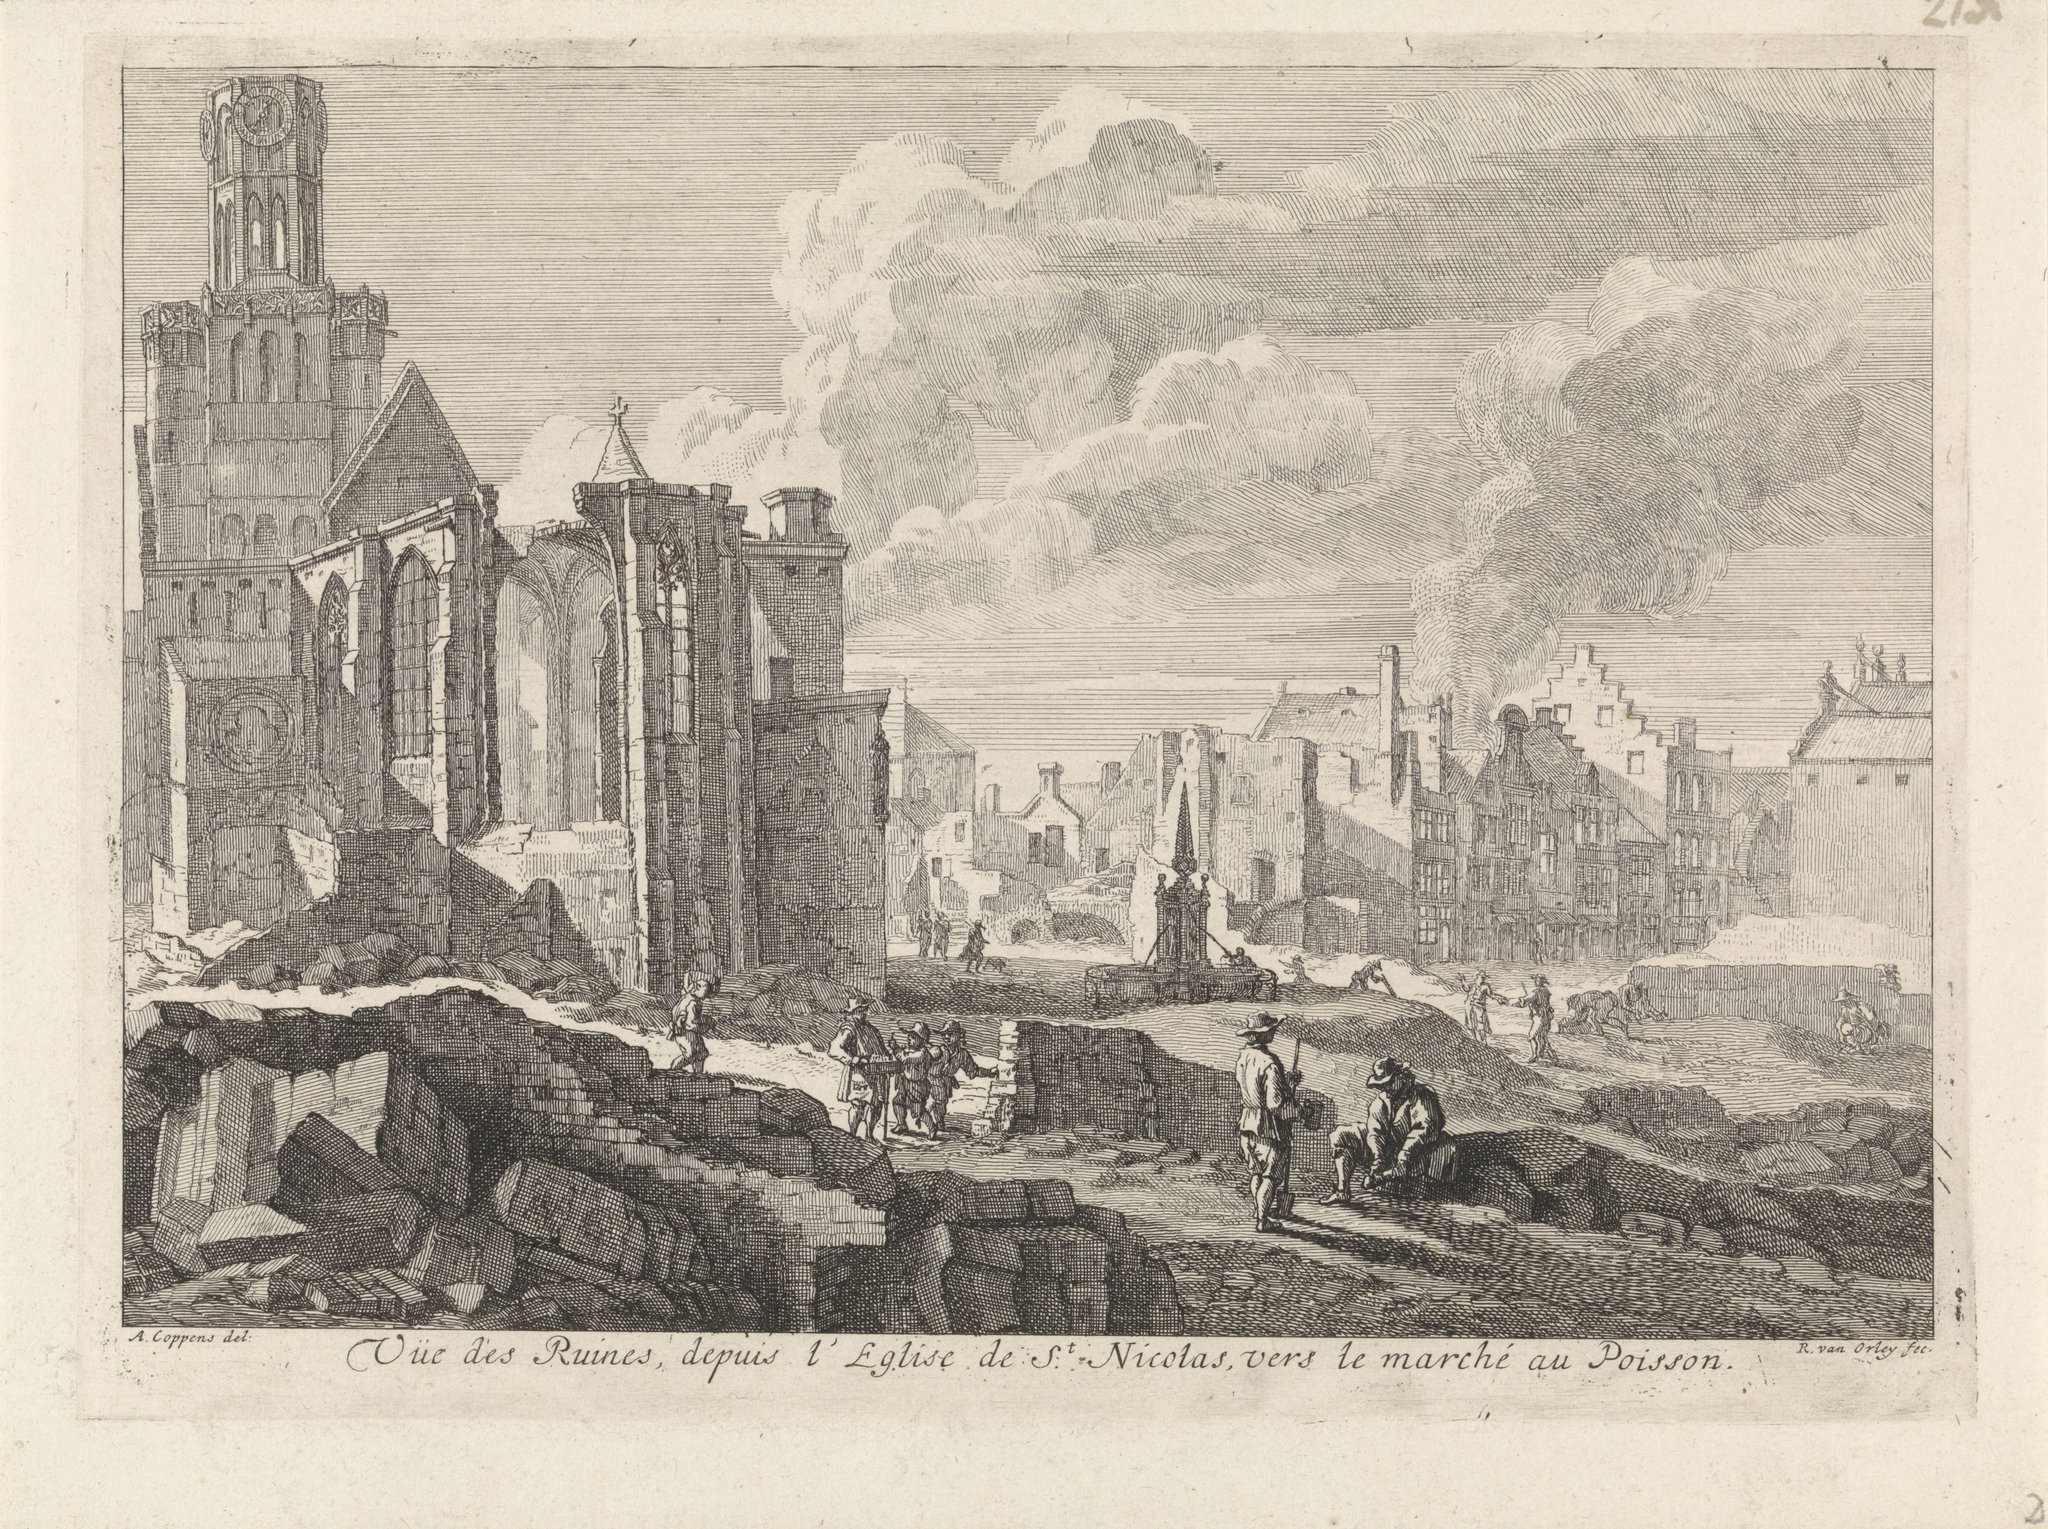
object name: print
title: Ruïnes bij de Vismarkt te Brussel, 1695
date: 1695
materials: paper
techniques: etching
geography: southern netherlands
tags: devastated, ruined place or city (~ warfare), brussels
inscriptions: collector's mark: Lugt 2228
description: Voorstelling van de ruïnes tussen de Sint-Nicolaaskerk en de Vismarkt te Brussel na het bombardement door de Fransen, 13-15 augustus 1695. Vierde prent in de reeks van twaalf.